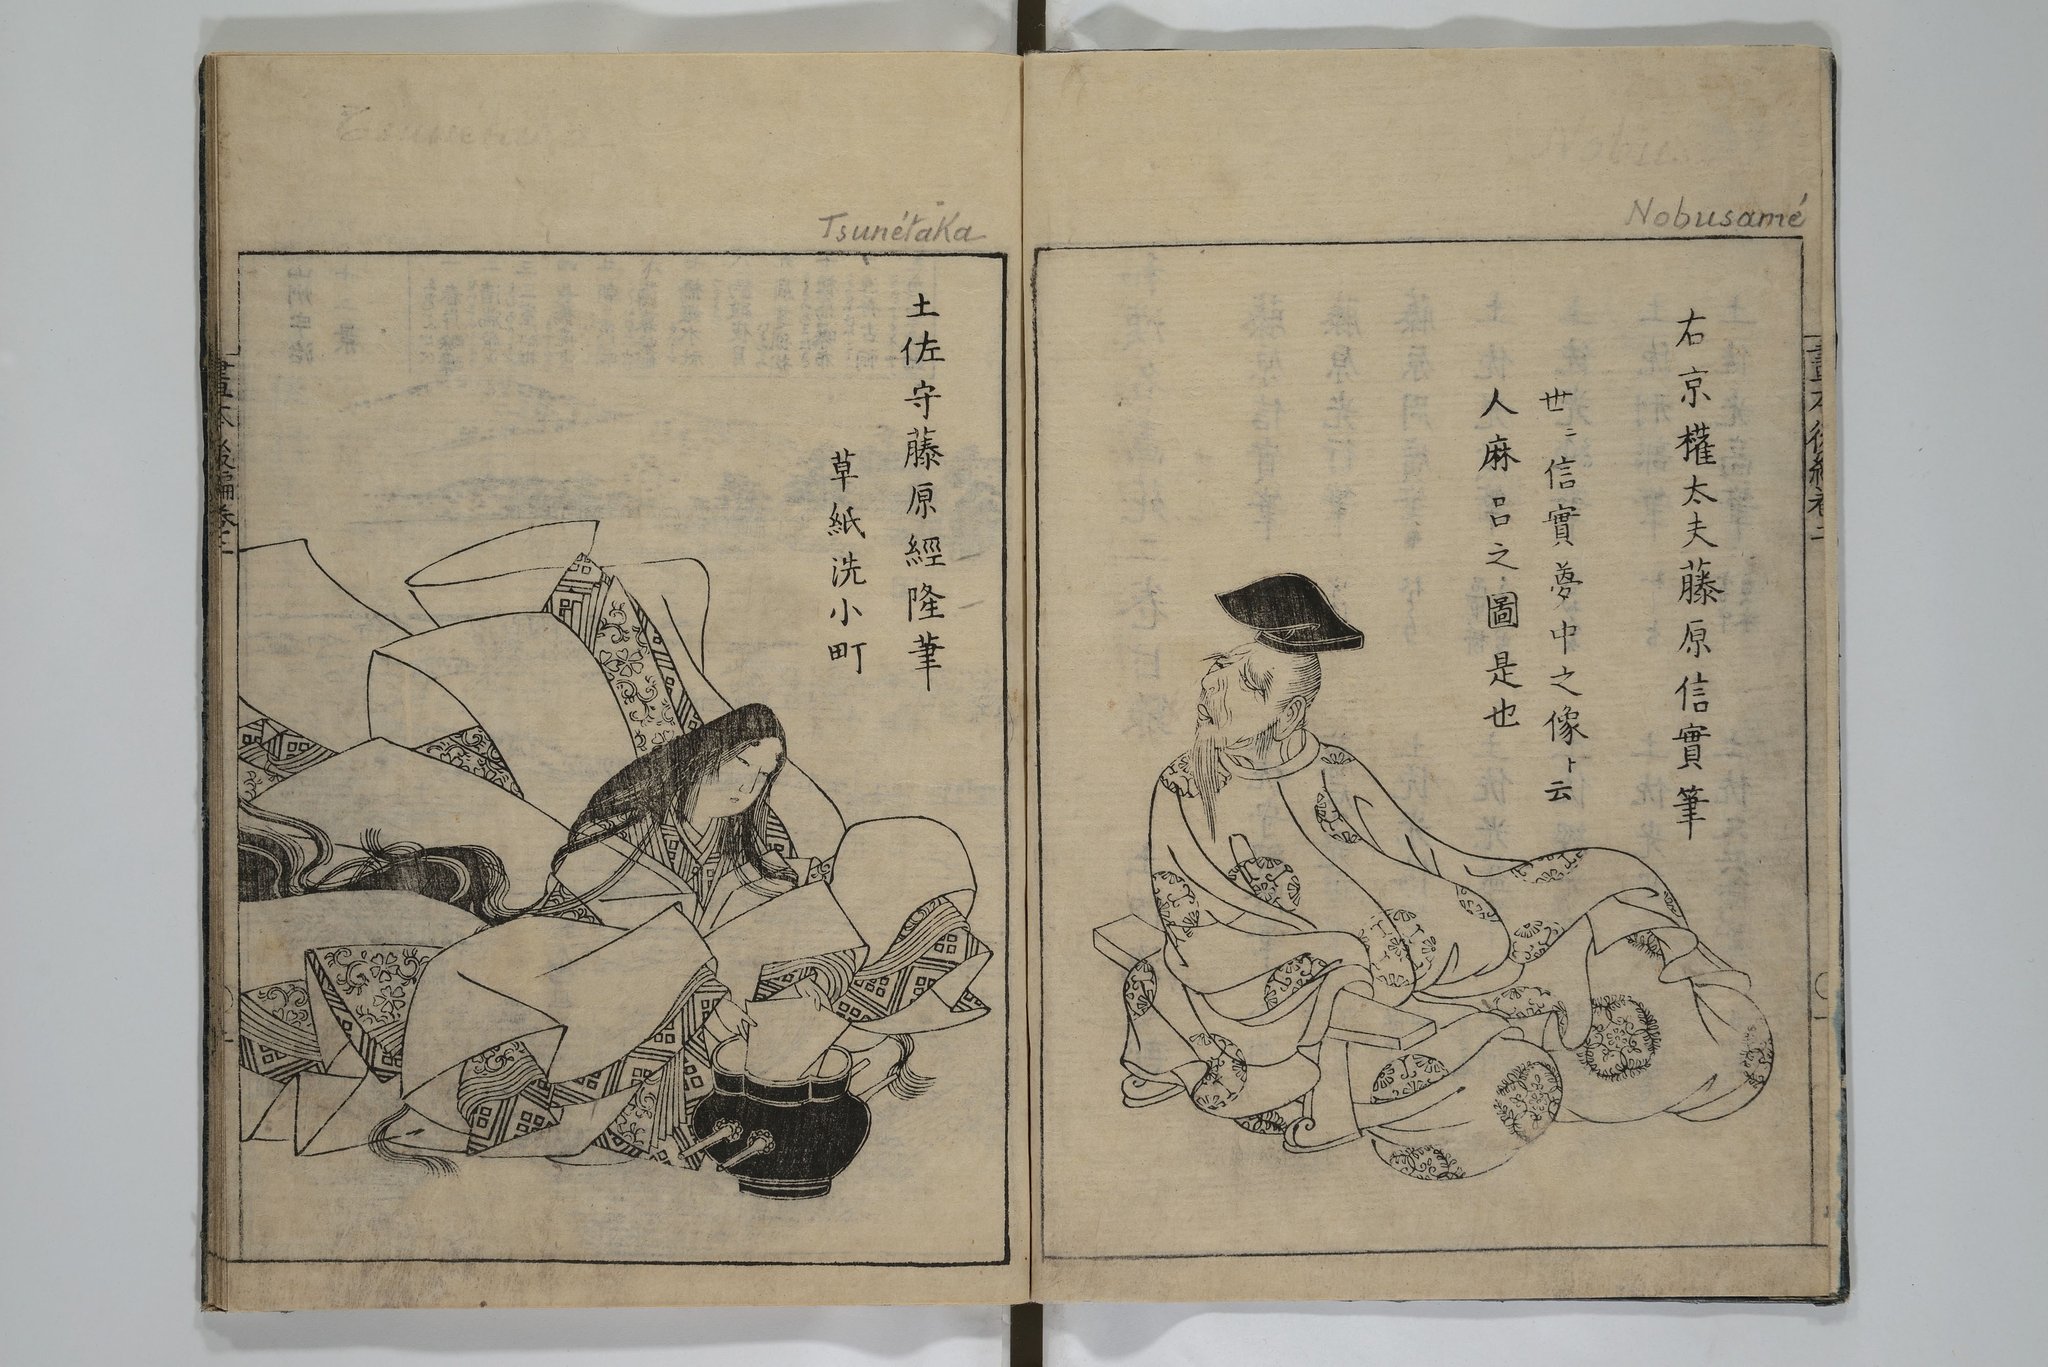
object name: illustrated book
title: A Garden of Celebrated Japanese and Chinese Paintings (Wakan meigaen} 和漢名画苑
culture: japanese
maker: ooka shunboku 大岡春卜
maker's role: artist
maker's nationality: japanese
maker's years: 1680-1763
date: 1750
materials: ink, paper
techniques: bookbinding, woodblock print